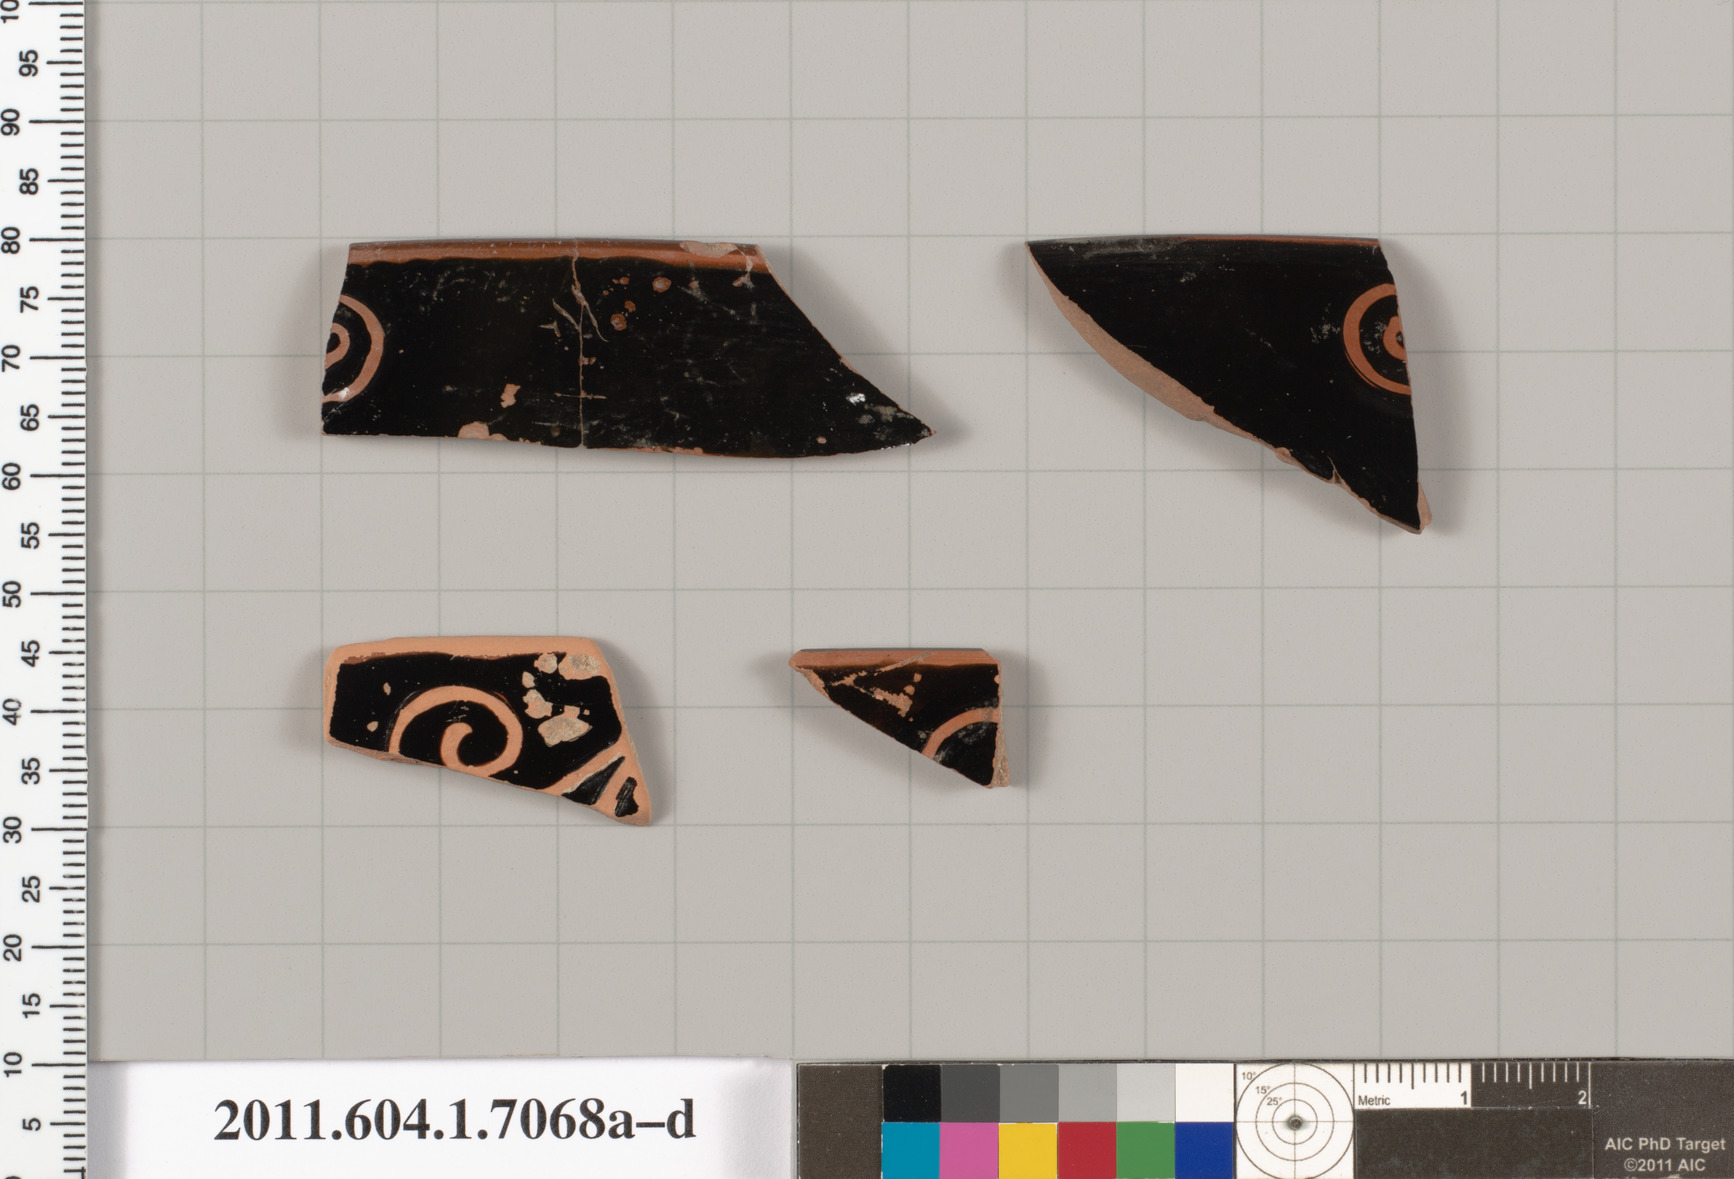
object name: kylix fragment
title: Terracotta rim fragments of kylikes (drinking cups)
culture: greek, attic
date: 500-480 BCE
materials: terracotta